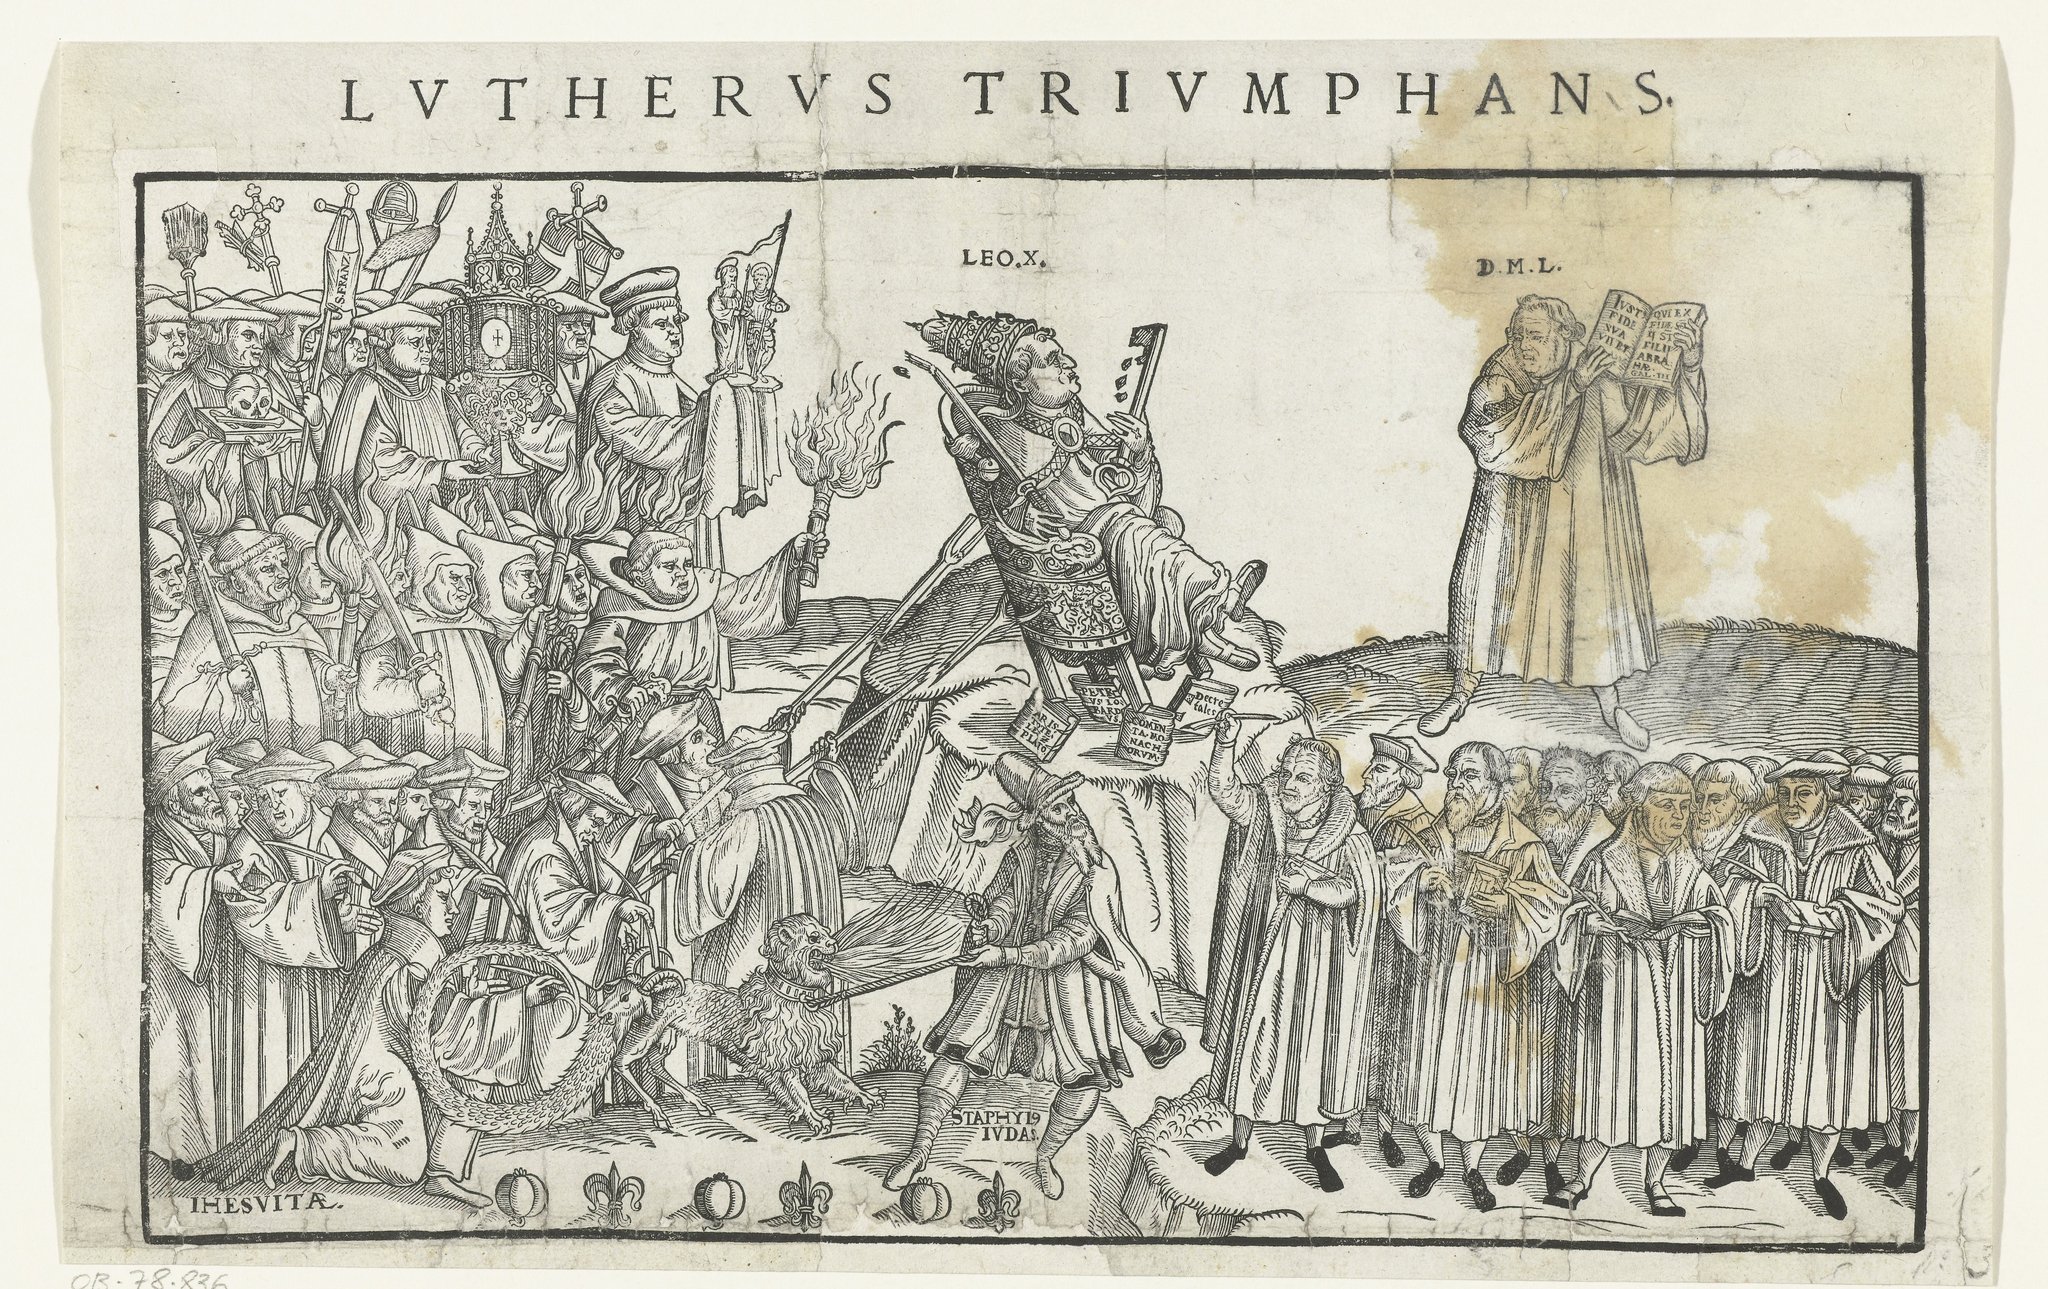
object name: print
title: Triomf van Luther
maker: Anonymous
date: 1566-1568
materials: paper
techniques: woodcut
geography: germany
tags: rome, leo x, priest, martin luther, reformation (roman catholic church vs. protestantism), pope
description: Triomf van Luther, ca. 1520-1550. De kerkhervormers geleid door Luther in contrast tegenover de katholieken aangevoerd door paus Leo X. Luther staande op een heuvel met de Bijbel in de handen, aan zijn voeten een leger van hervormers waaronder Melanchton en Hus. Links de vereende krachten van allerlei strijdbare exponenten uit de Roomse kerk: jezuïeten, monniken met fakkels, kerkgeleerden met schrijfpennen en gewapend met liturgische objecten. Centraal de paus gezeten op een wankele troon welke op het punt staat om te vallen. Op de voorgrond Friedrich Stapellage (Staphylus), een tot het katholicisme bekeerde prostestant. Titelprent van een pamflet uit 1568. Spotprent op de Roomse kerk.